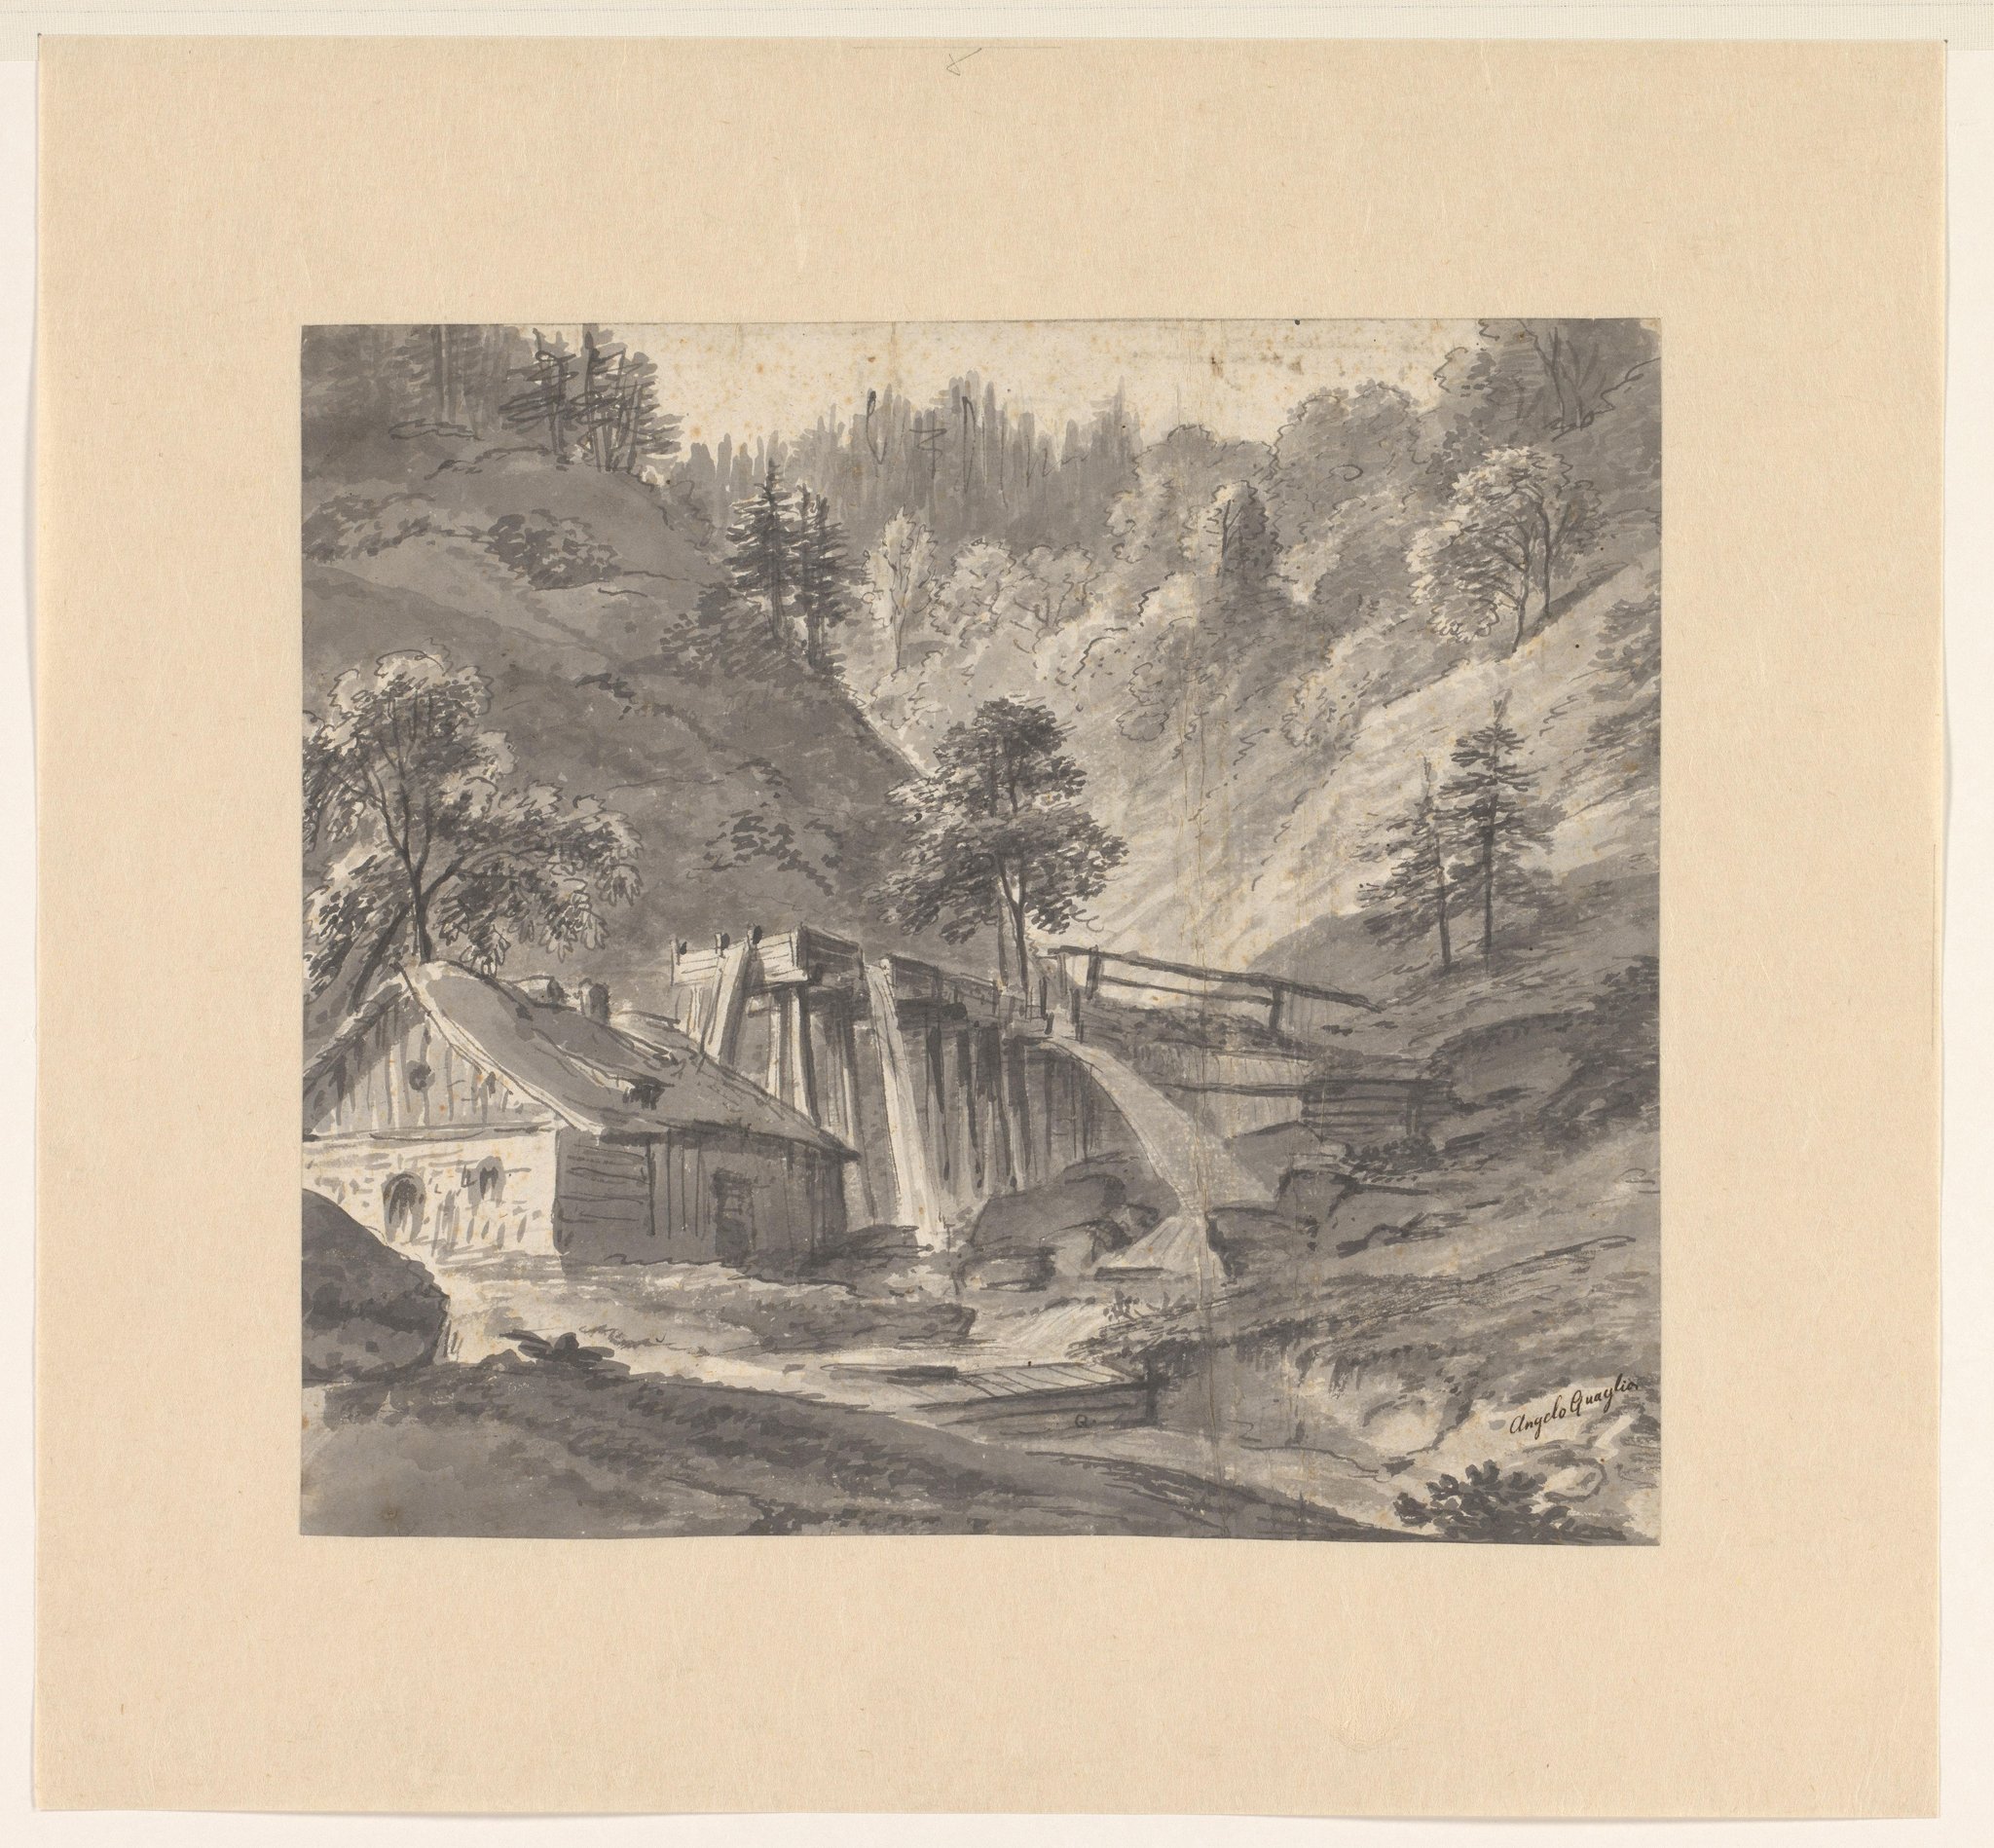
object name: drawing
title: Waterval in de bergen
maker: angelo quaglio (i)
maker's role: painter, print maker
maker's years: 1778-1815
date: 1788-1815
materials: ink, paper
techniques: brush, pen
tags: waterfall